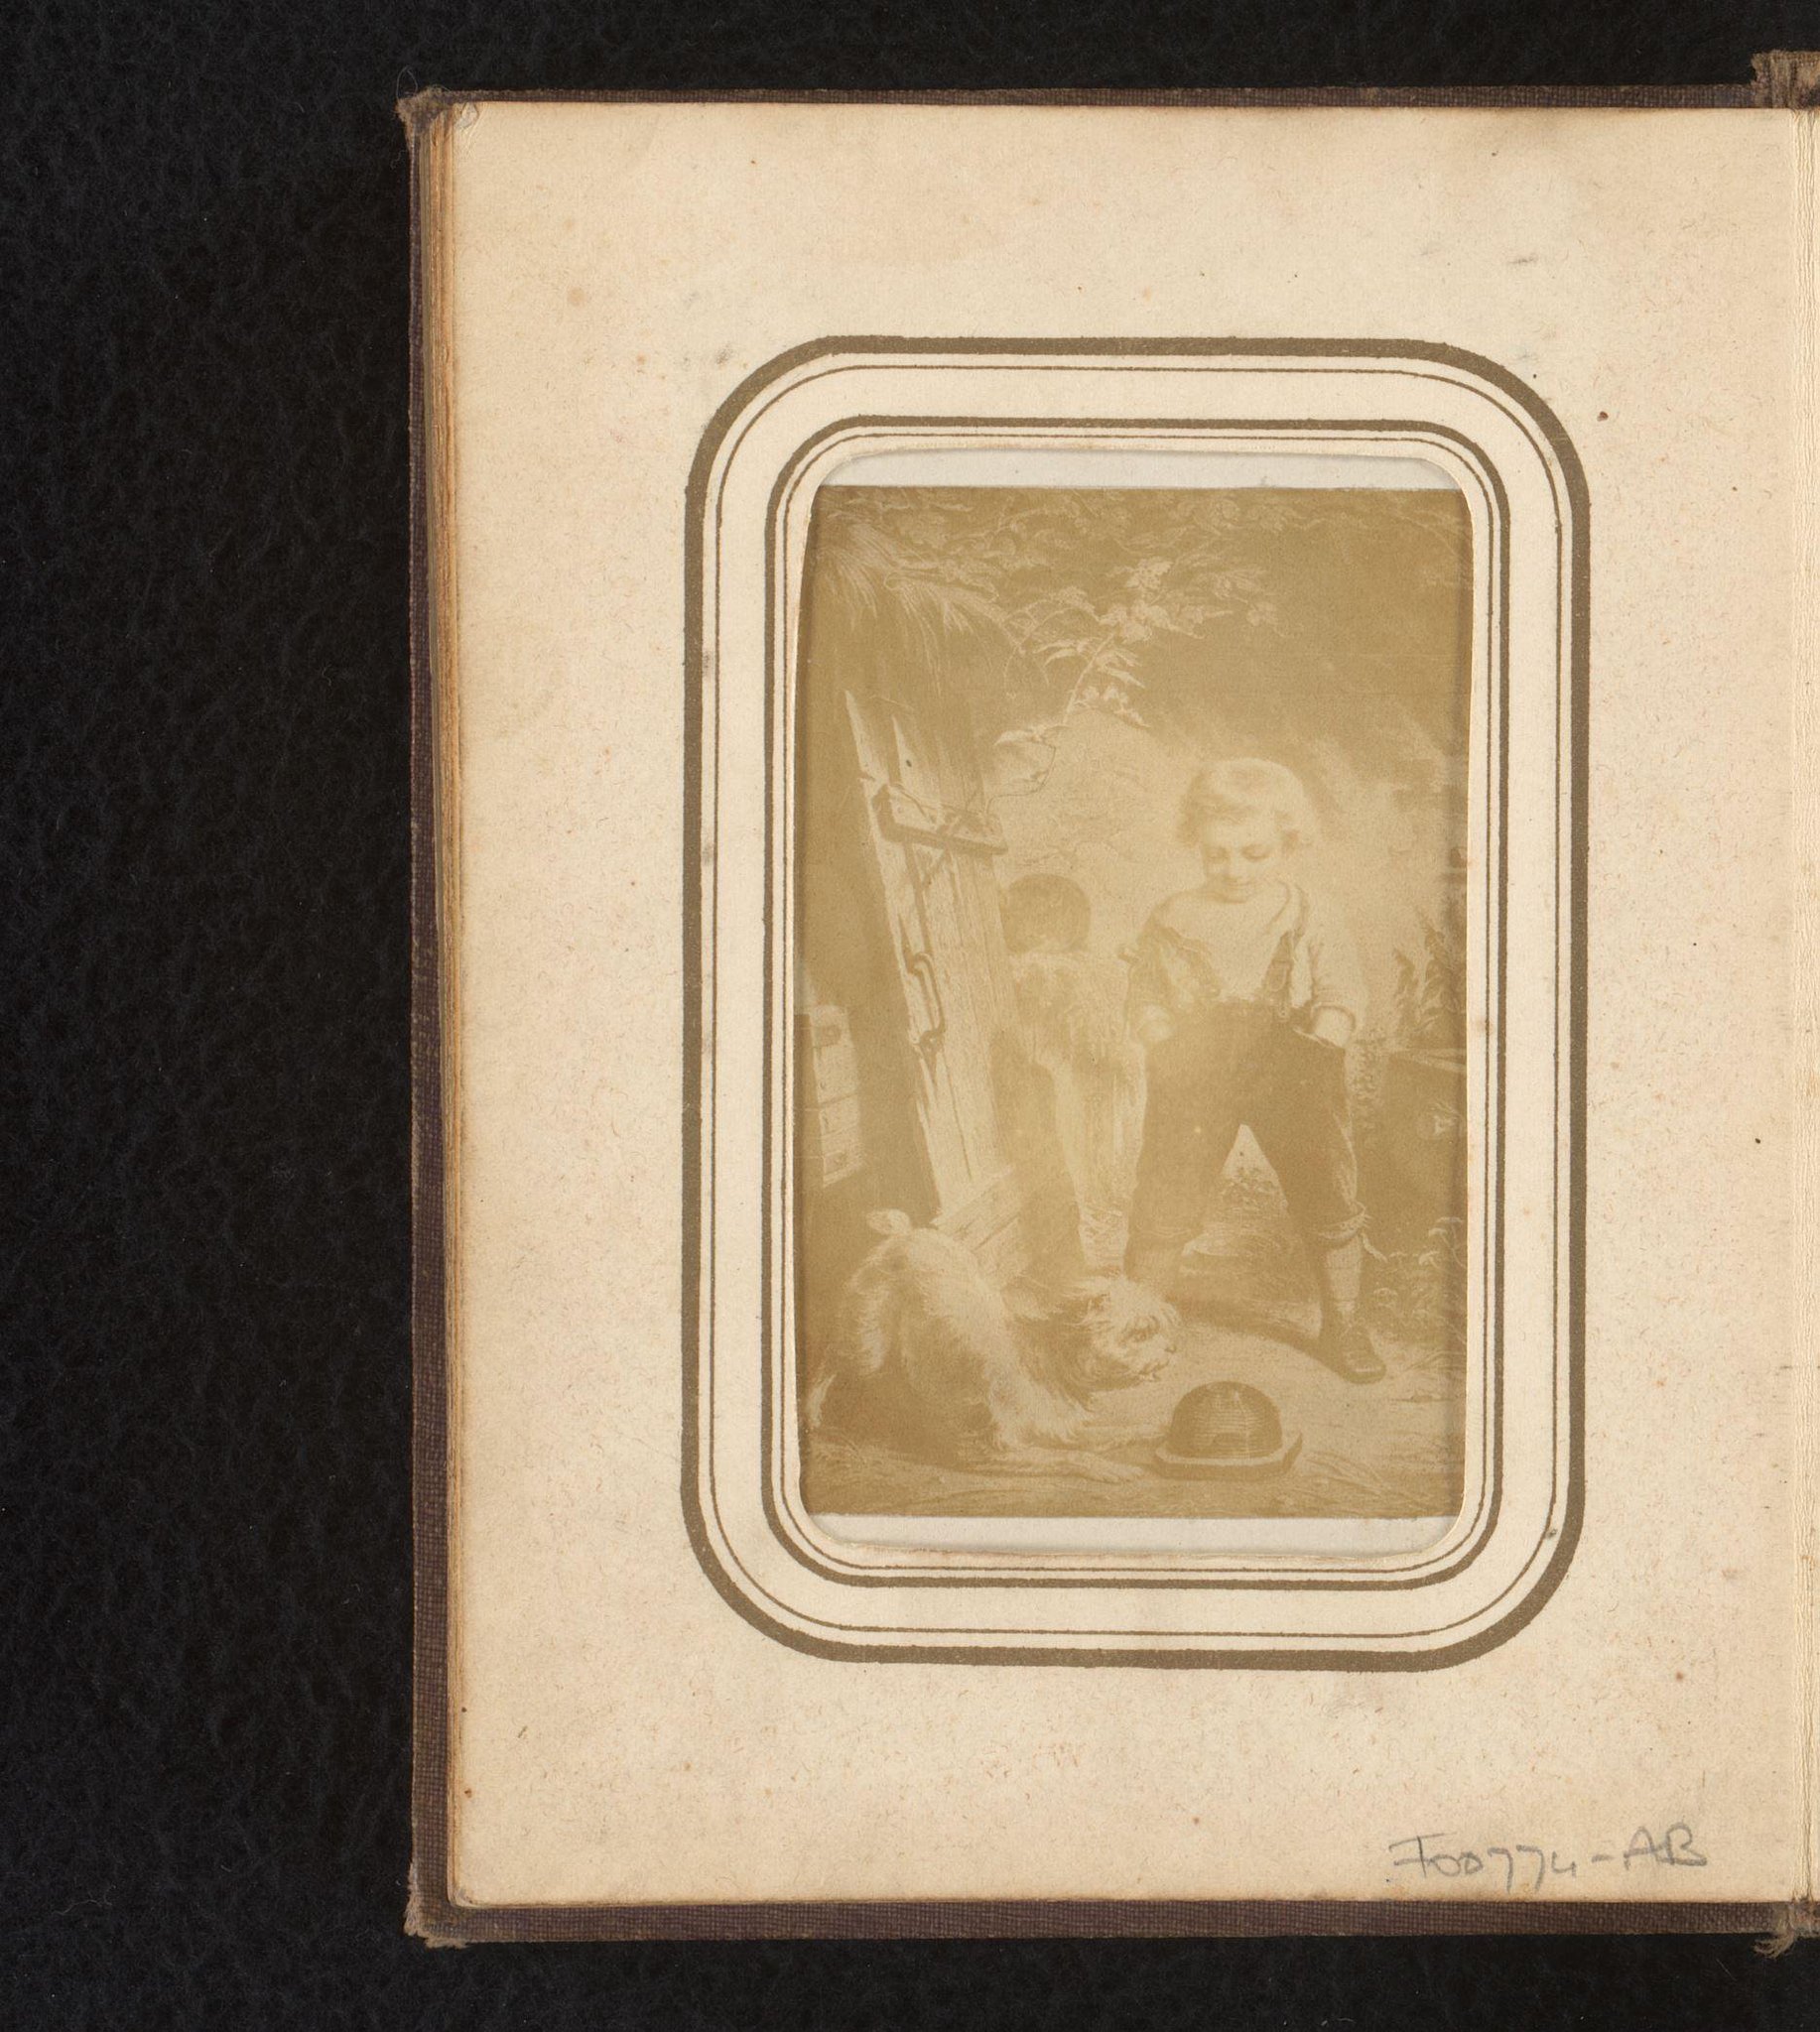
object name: reproduction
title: Fotoreproductie van een schilderij van een jongen en hond bij een kooi met een muis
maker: Anonymous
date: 1850-1900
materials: cardboard, photographic support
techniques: albumen print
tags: rodents: mouse, toddler (male), dog